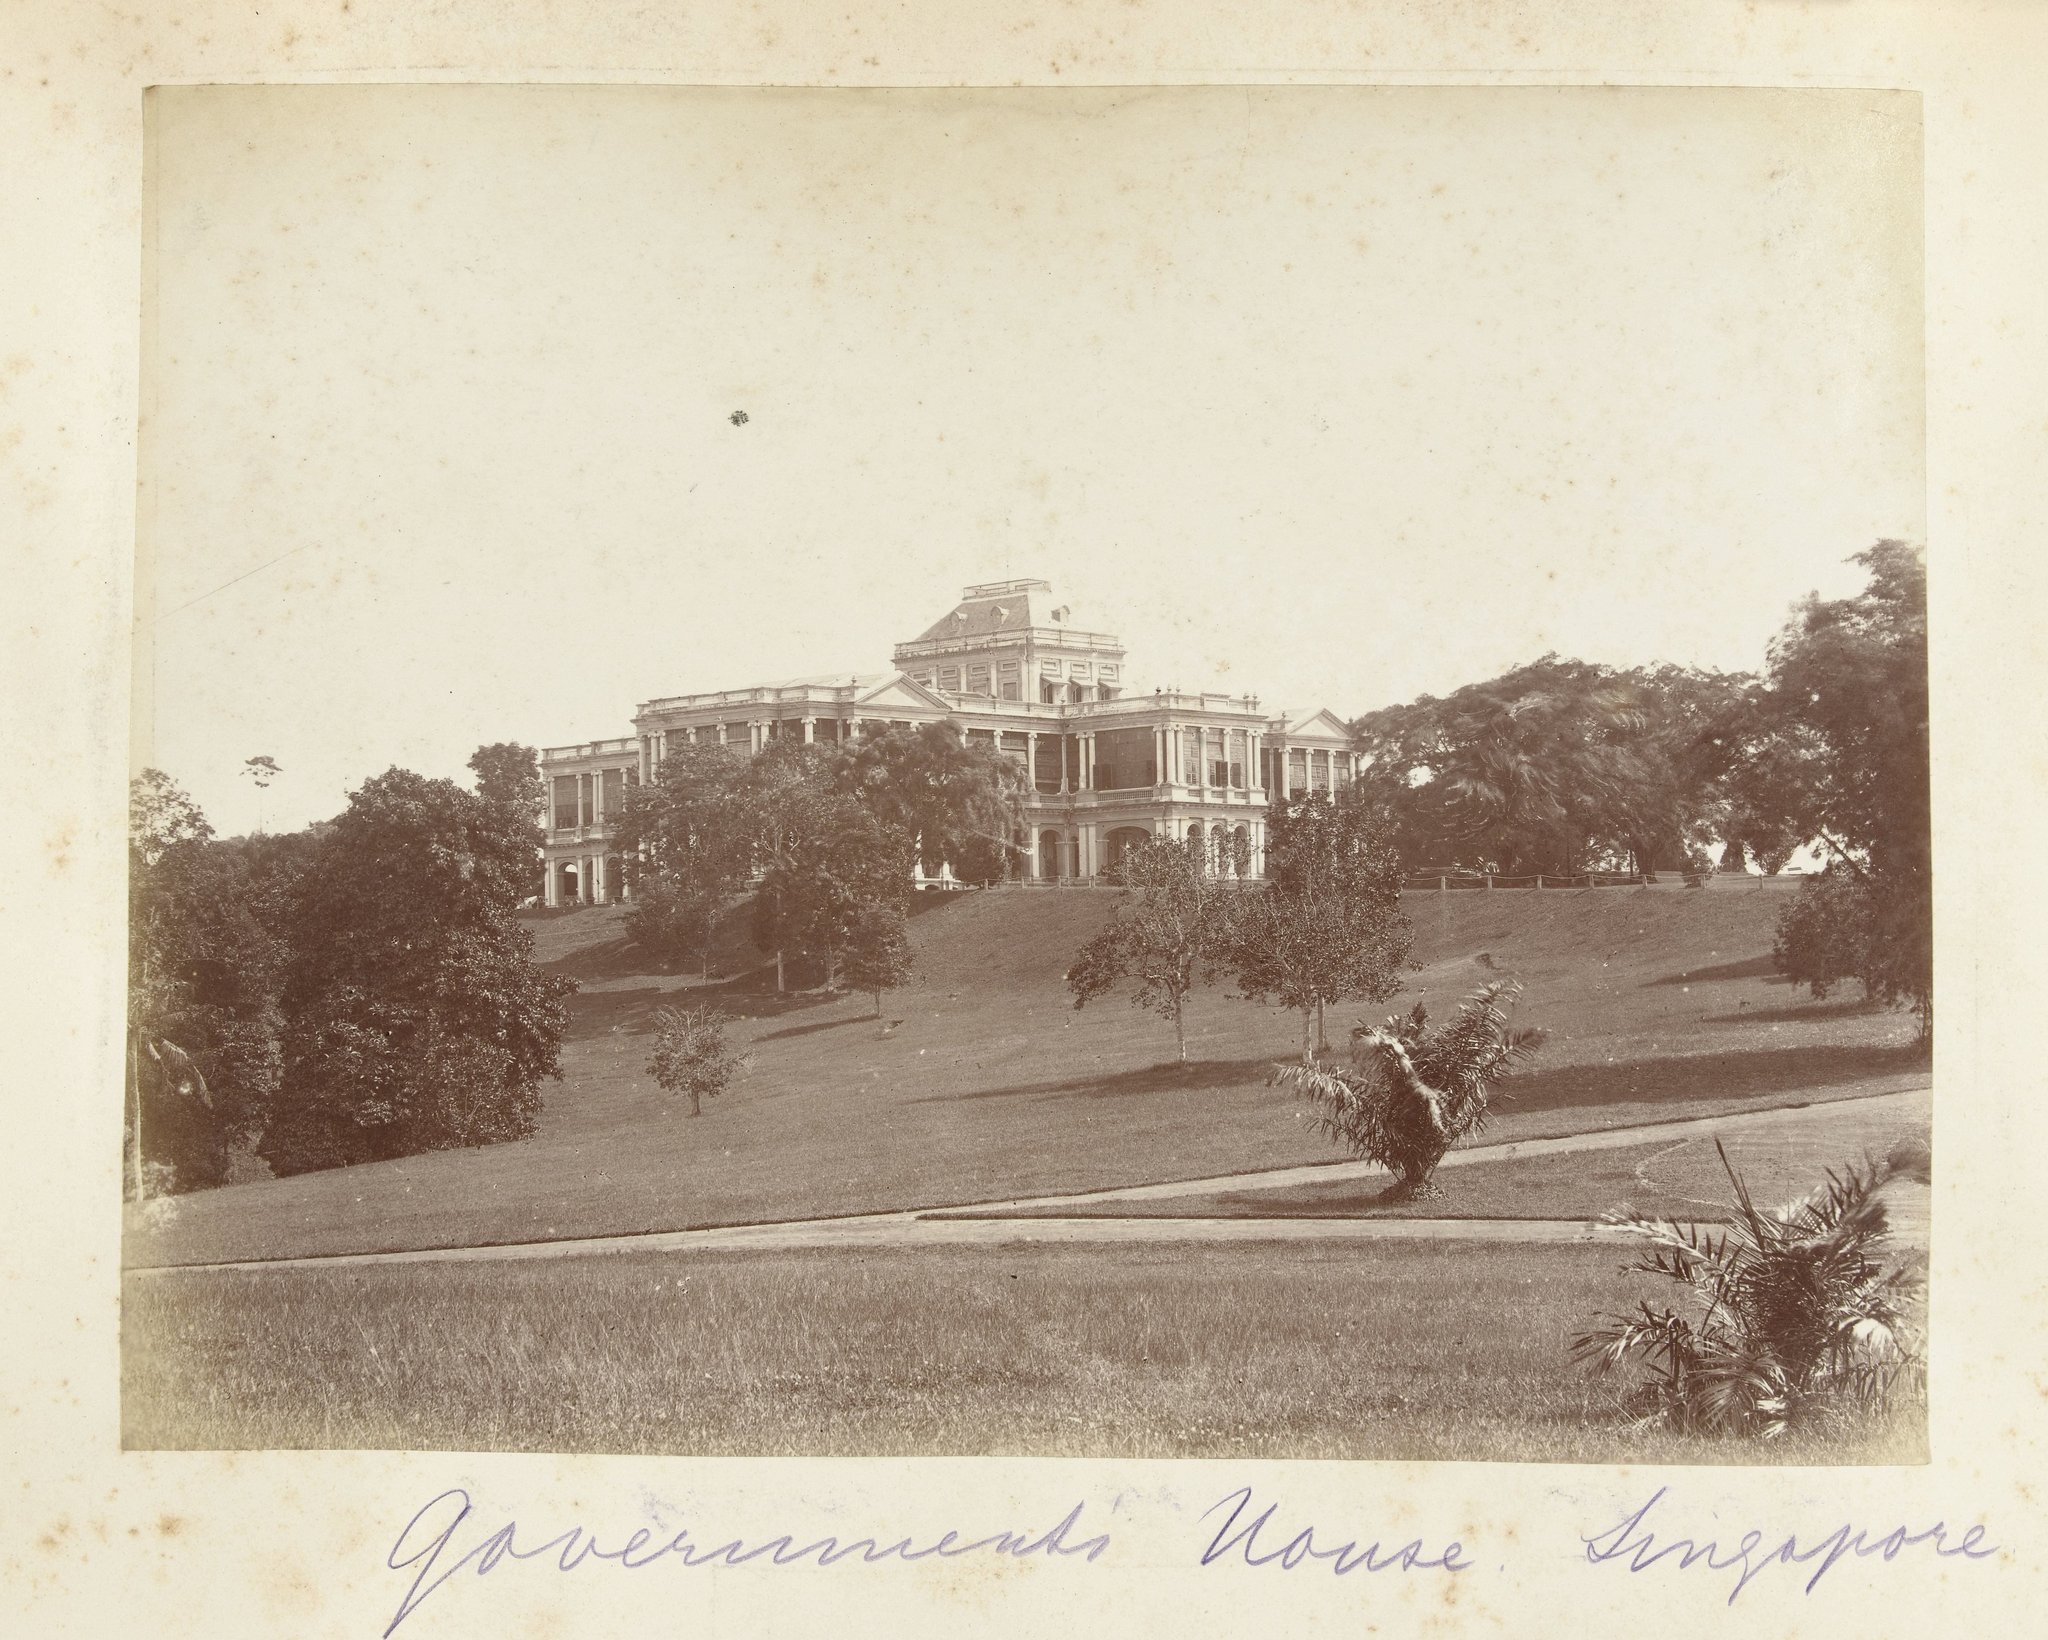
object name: photograph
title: Het gouvernementshuis in Singapore en het nabijgelegen park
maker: Anonymous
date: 1890-1910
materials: cardboard, paper, photographic support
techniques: gelatin silver print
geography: singapore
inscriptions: title: ‘Post office and exchange building S. 743’, caption: ‘Post office and exchange building Singapore’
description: Te zien zijn het postkantoor en het wisselkantoor, beide gebouwen met een Europees uiterlijk